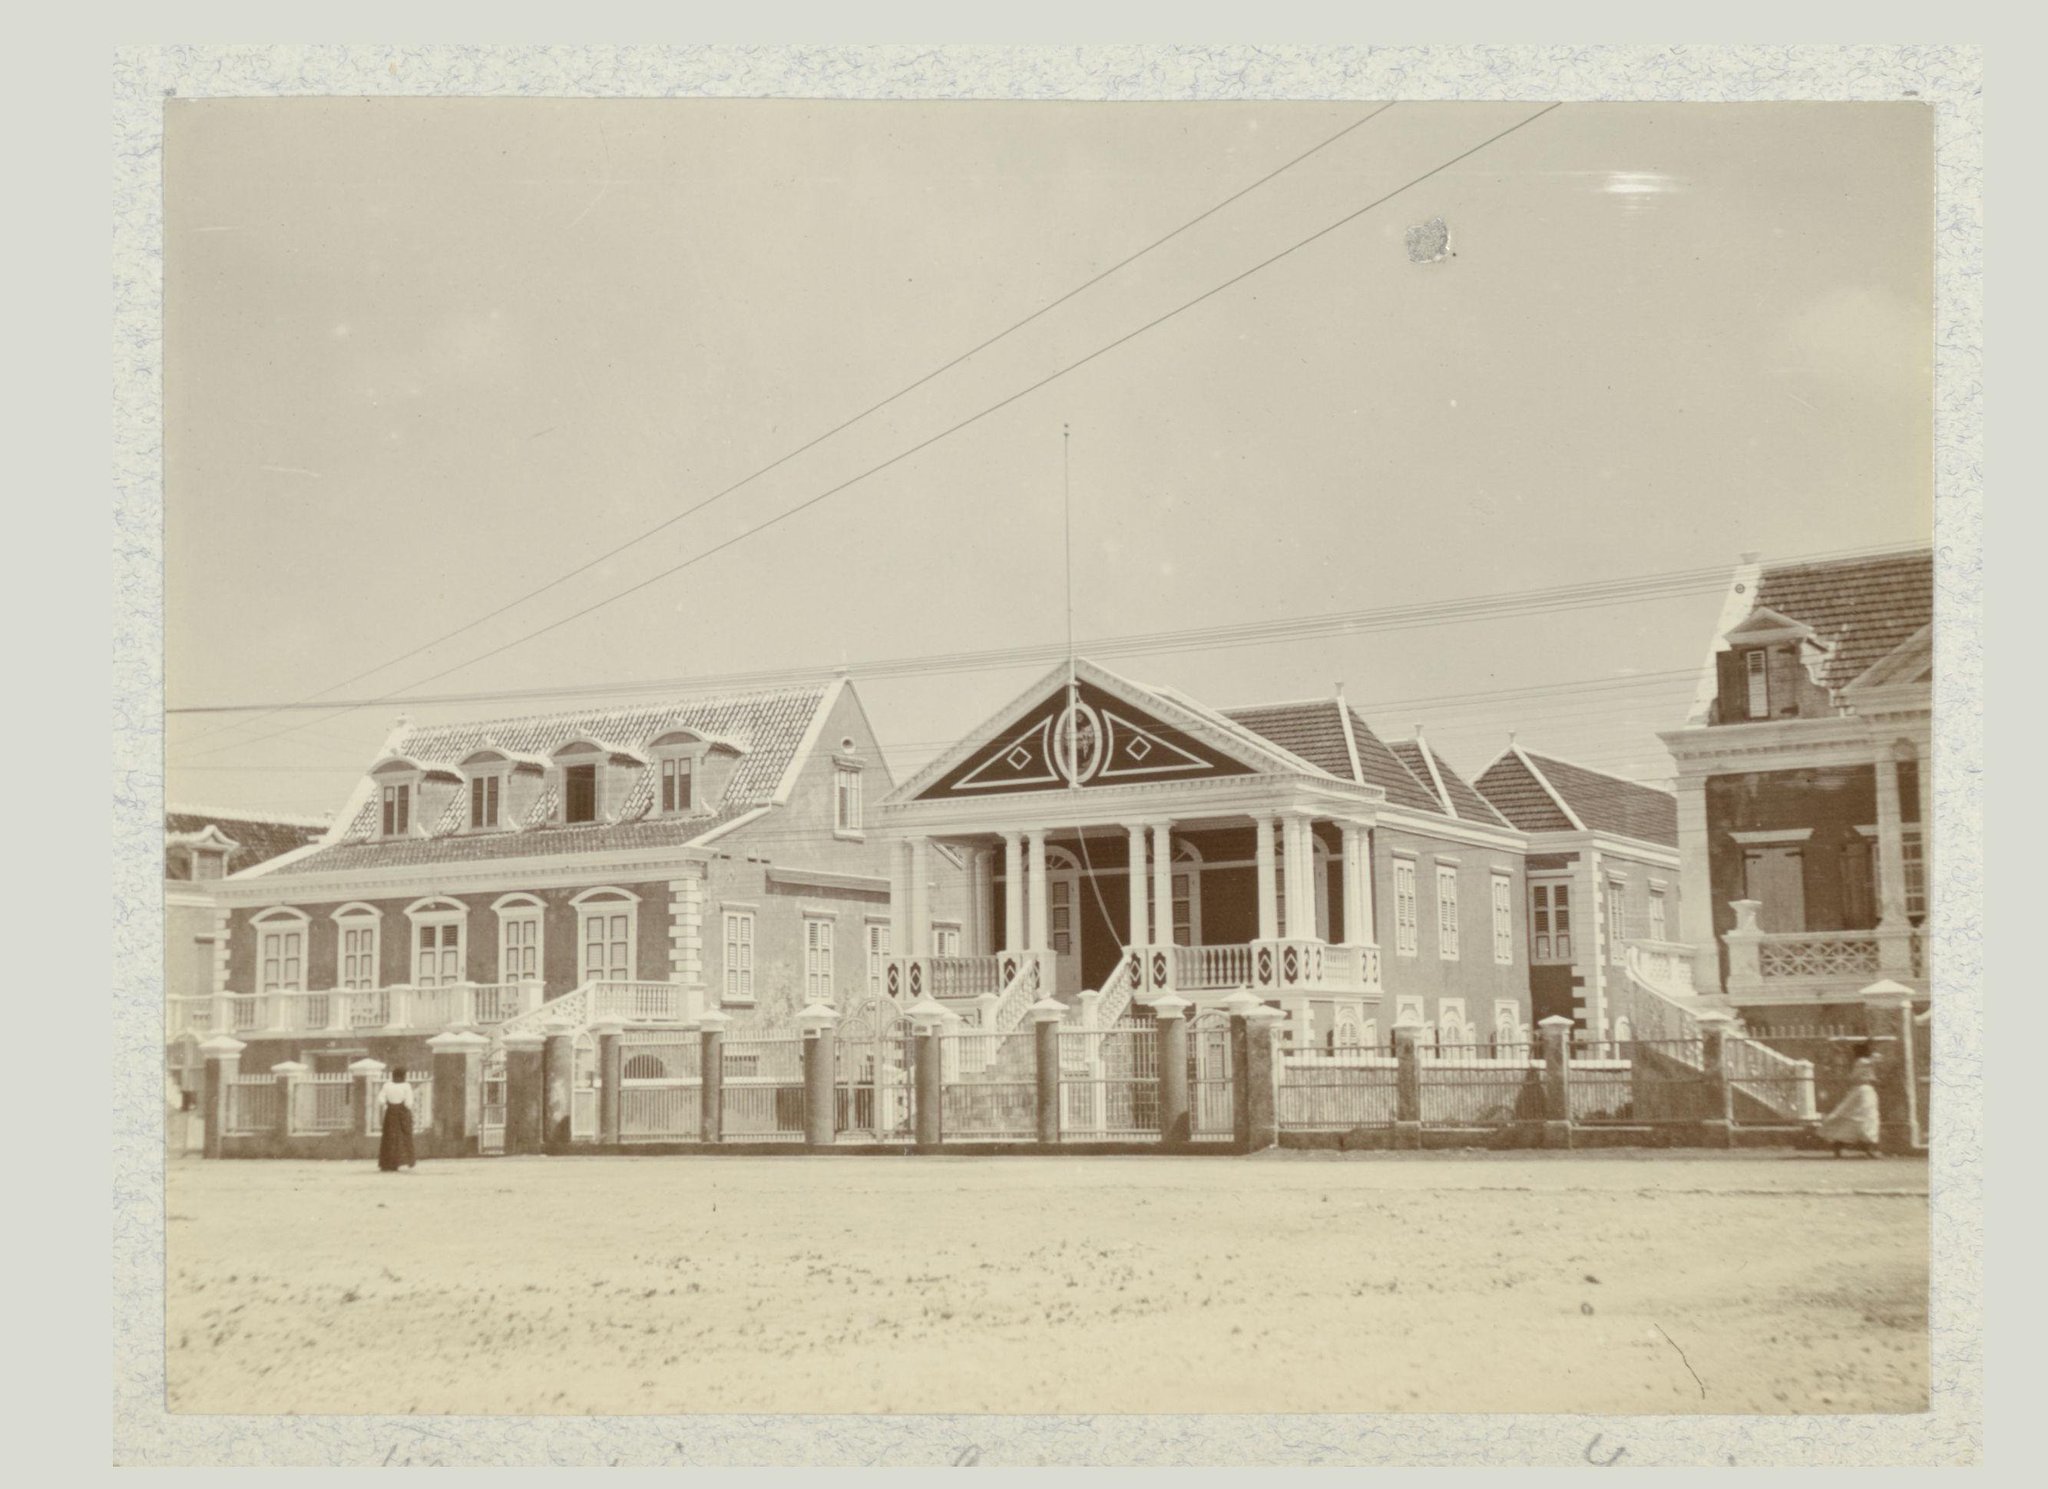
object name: photograph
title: Gekleurde huizen in Willemstad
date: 1906-1910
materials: photographic support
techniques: photography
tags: city-view in general; 'veduta'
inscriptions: inscription: ‘Kleuren huizen op Curaçao. Juni 1910’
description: Gekleurde huizen aan een straat in Willemstad op Curaçao, juni 1910. Onderdeel van het fotoalbum van de familie Boom-Gonggrijp in Suriname en Curaçao.